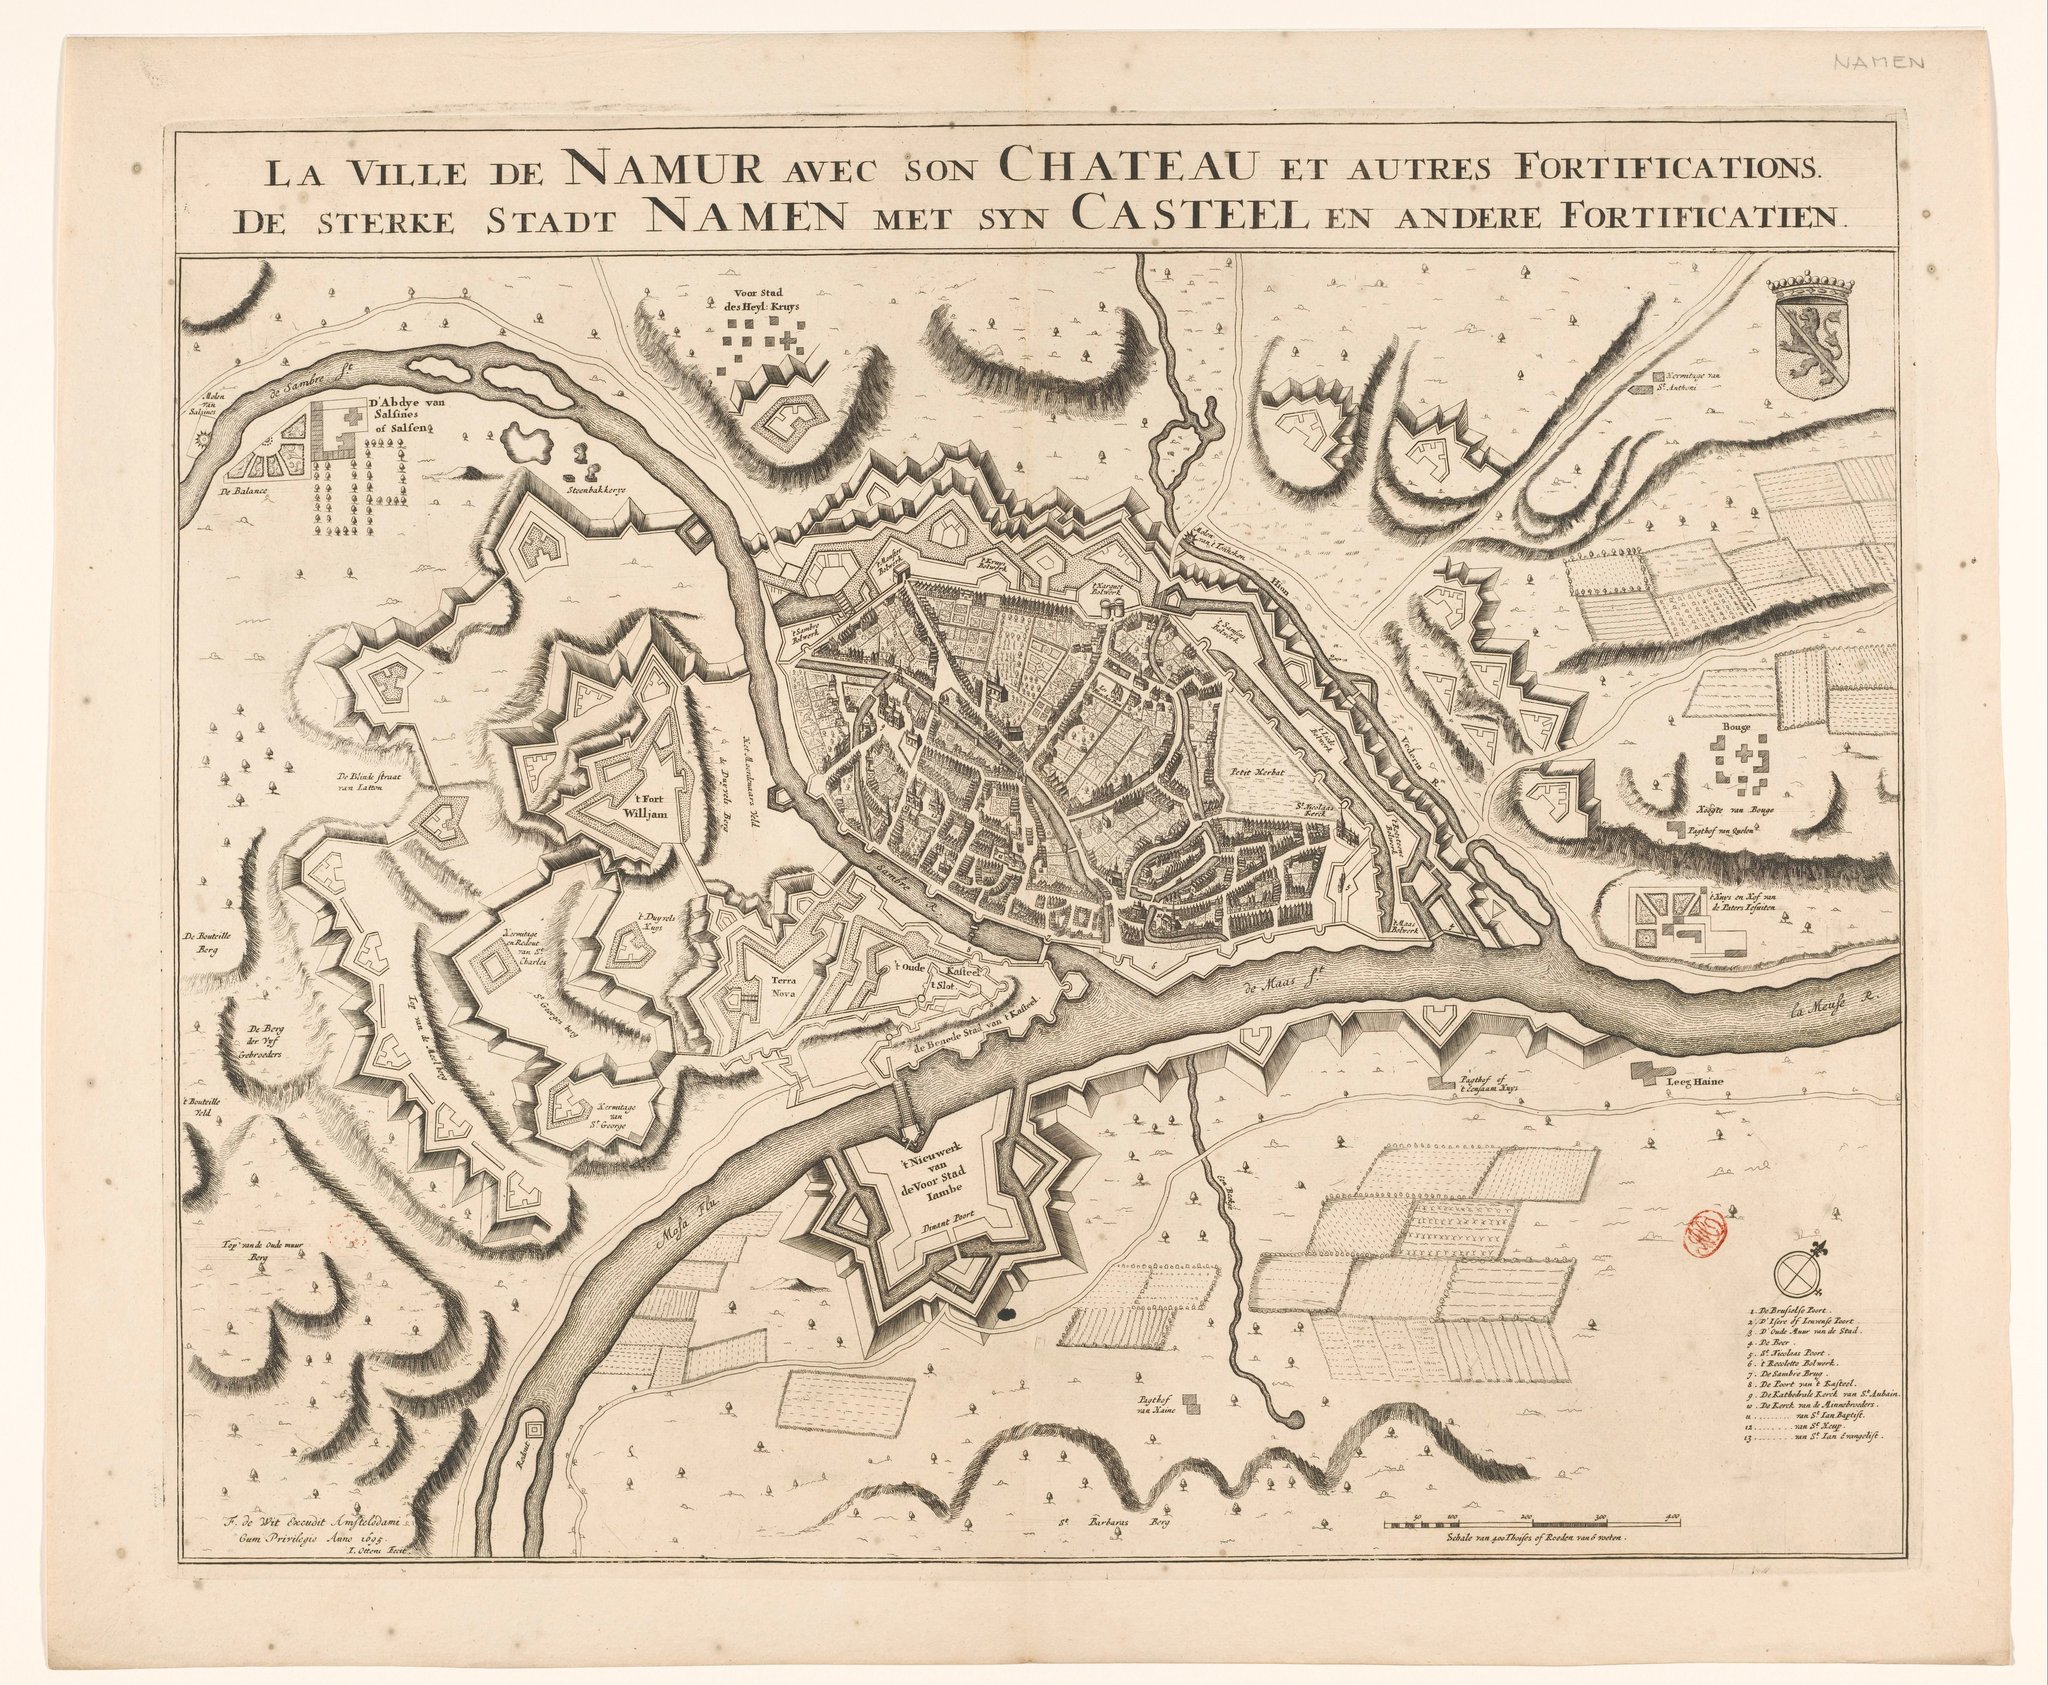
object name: print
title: La ville de Namur avec son chateau et autres fortifications / De sterke stadt Namen met syn casteel en andere fortificatien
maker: joachim ottens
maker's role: print maker, publisher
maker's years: 1663-1719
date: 1698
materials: paper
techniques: engraving, etching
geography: amsterdam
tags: fortified city, maps of cities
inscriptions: collector's mark: Lugt 195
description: Prent ook gebruikt in: Theatrum ichnographicum omnium urbium et praecipuorum oppidorum Belgicarum XVII Provinciarum (…). Amsterdam: Frederik de Wit, ca. 1700-1710. En in: Aa, Pieter van der. La galerie agreable du monde (…). 66 delen. Leiden: Pieter van der Aa, 1728, dl. 15.